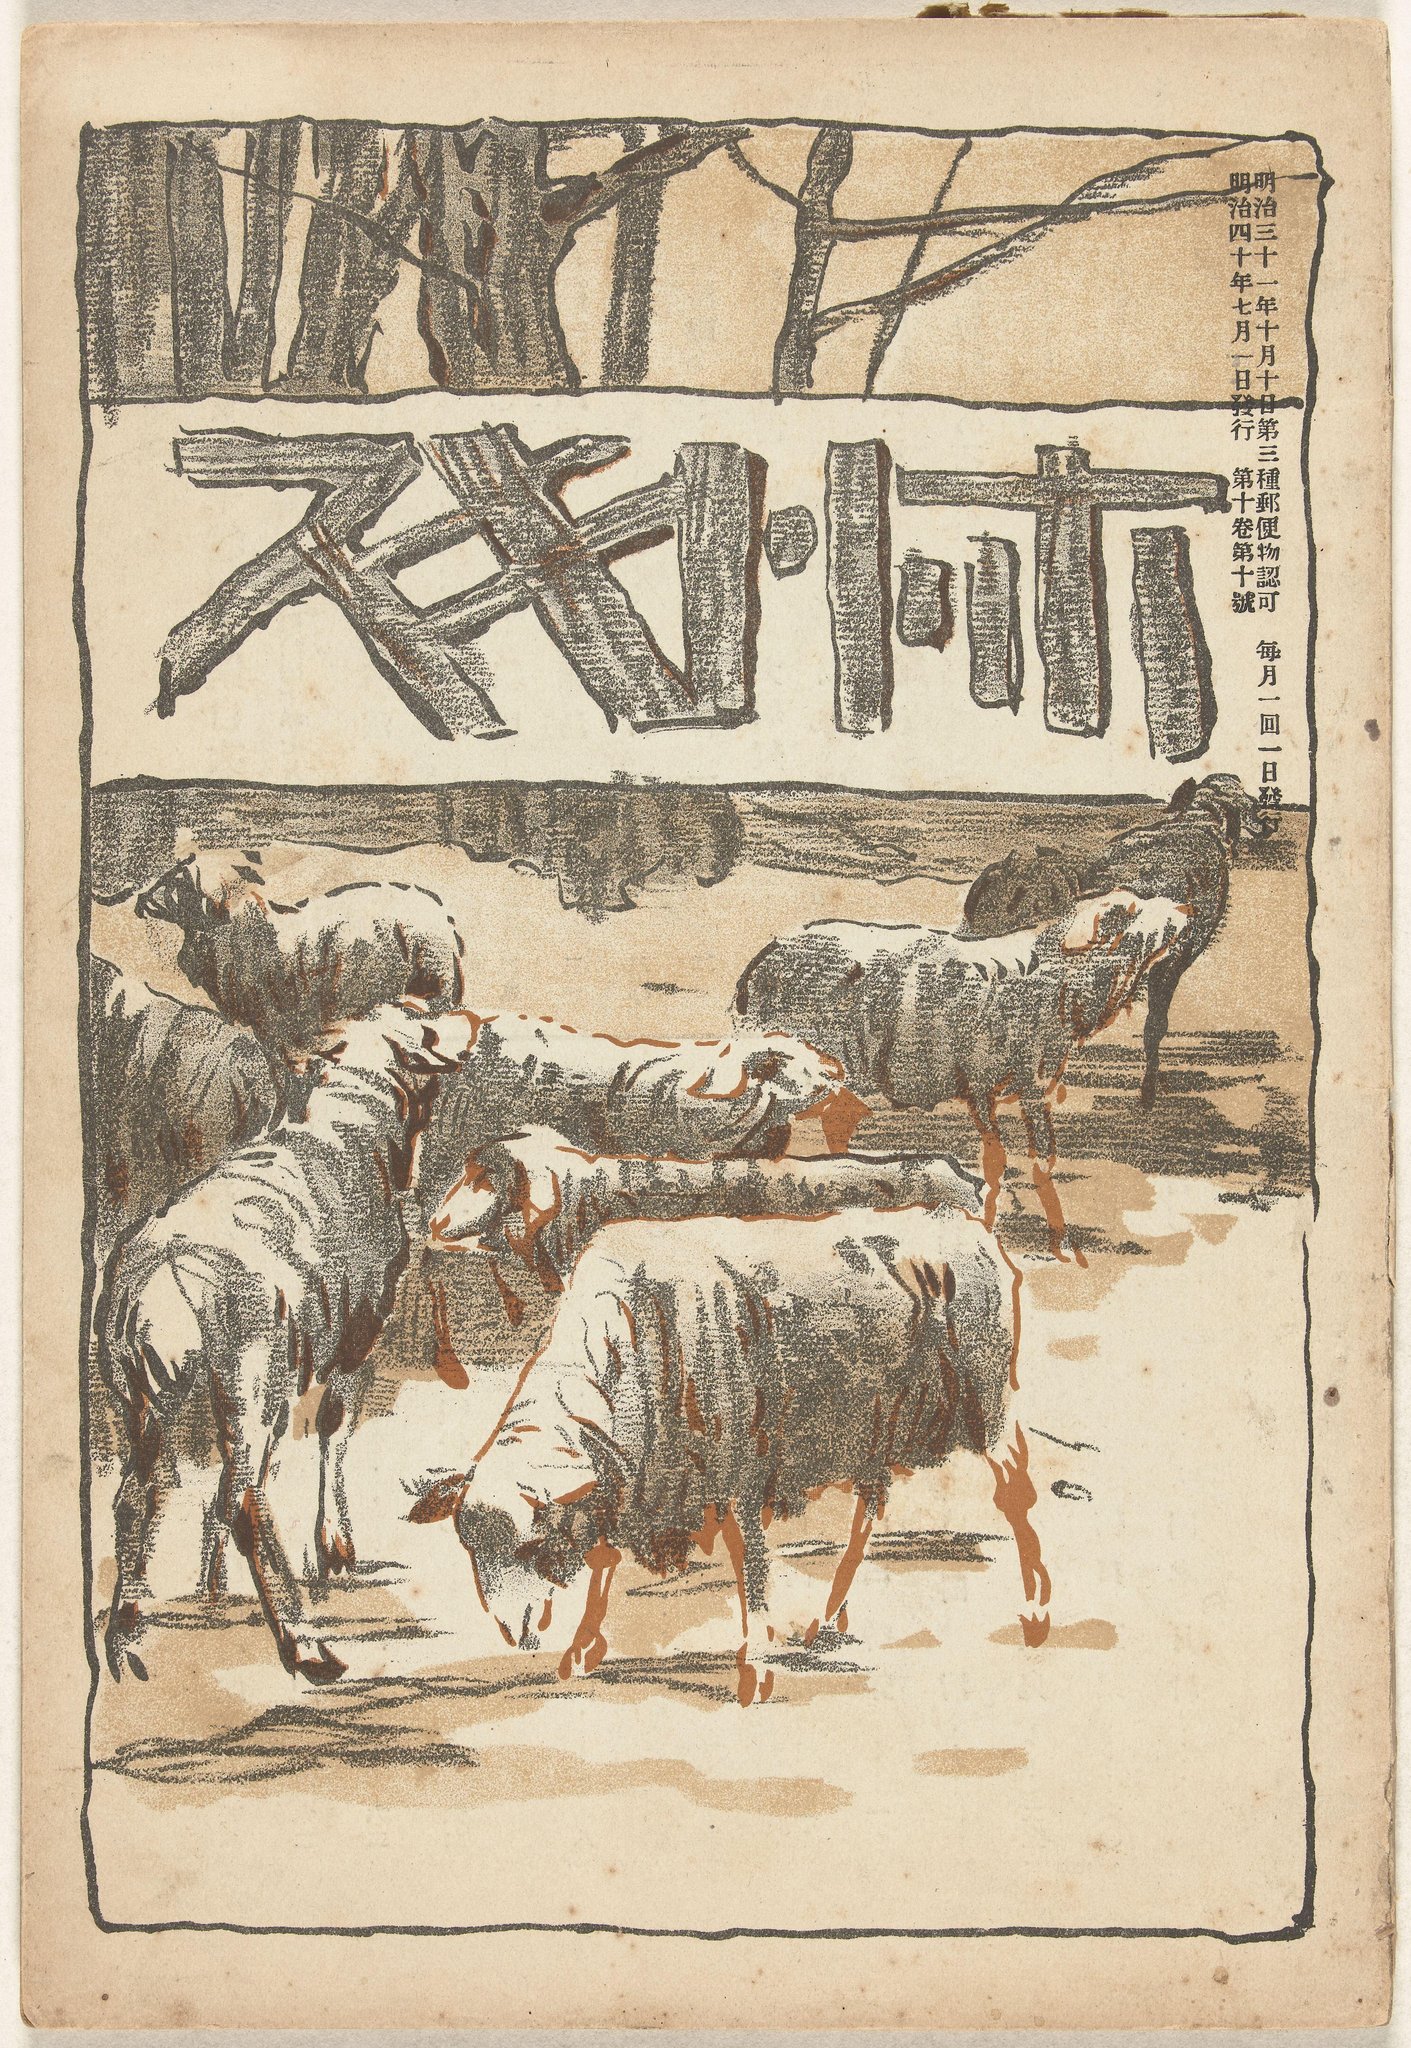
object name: book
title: Hototogisu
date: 1907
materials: paper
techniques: woodcut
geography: japan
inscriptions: date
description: Nummer 10 van jaargang 10 (juli 1907) van het literaire maandblad Hototogisu: kaft met afbeelding van schapen in grijs en bruin en titel in grijs; achterkant, afbeelding van danser met hoed.